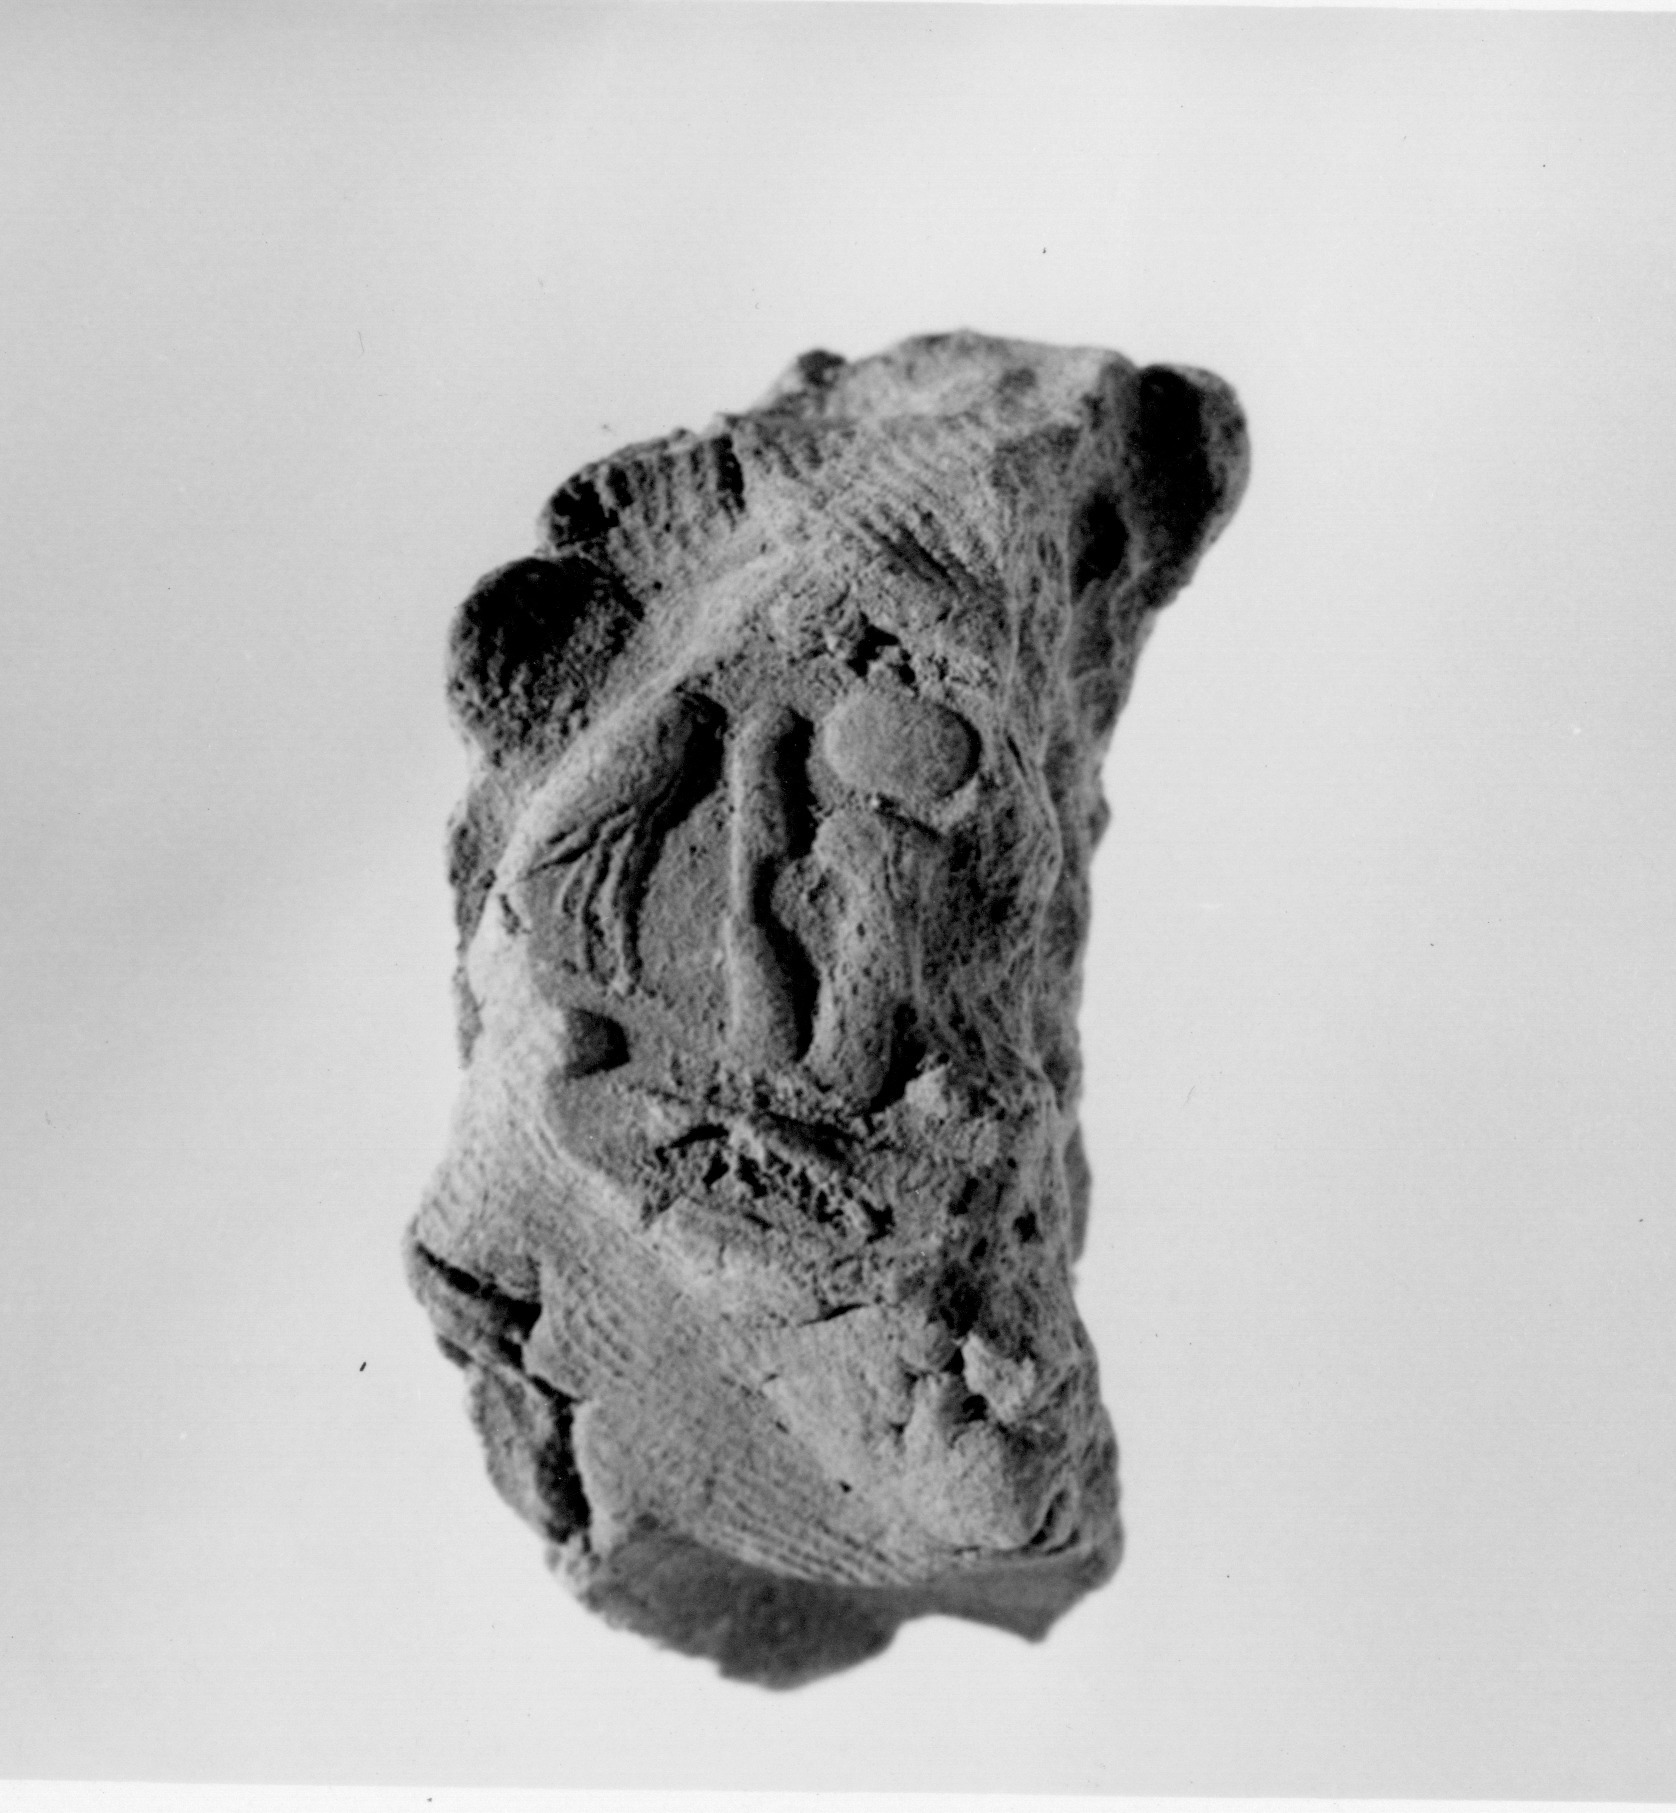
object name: sealing, nebmaatre, amenhotep iii,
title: Document Sealing With the Throne Name of Amenhotep III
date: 1390-1352 BCE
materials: mud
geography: egypt